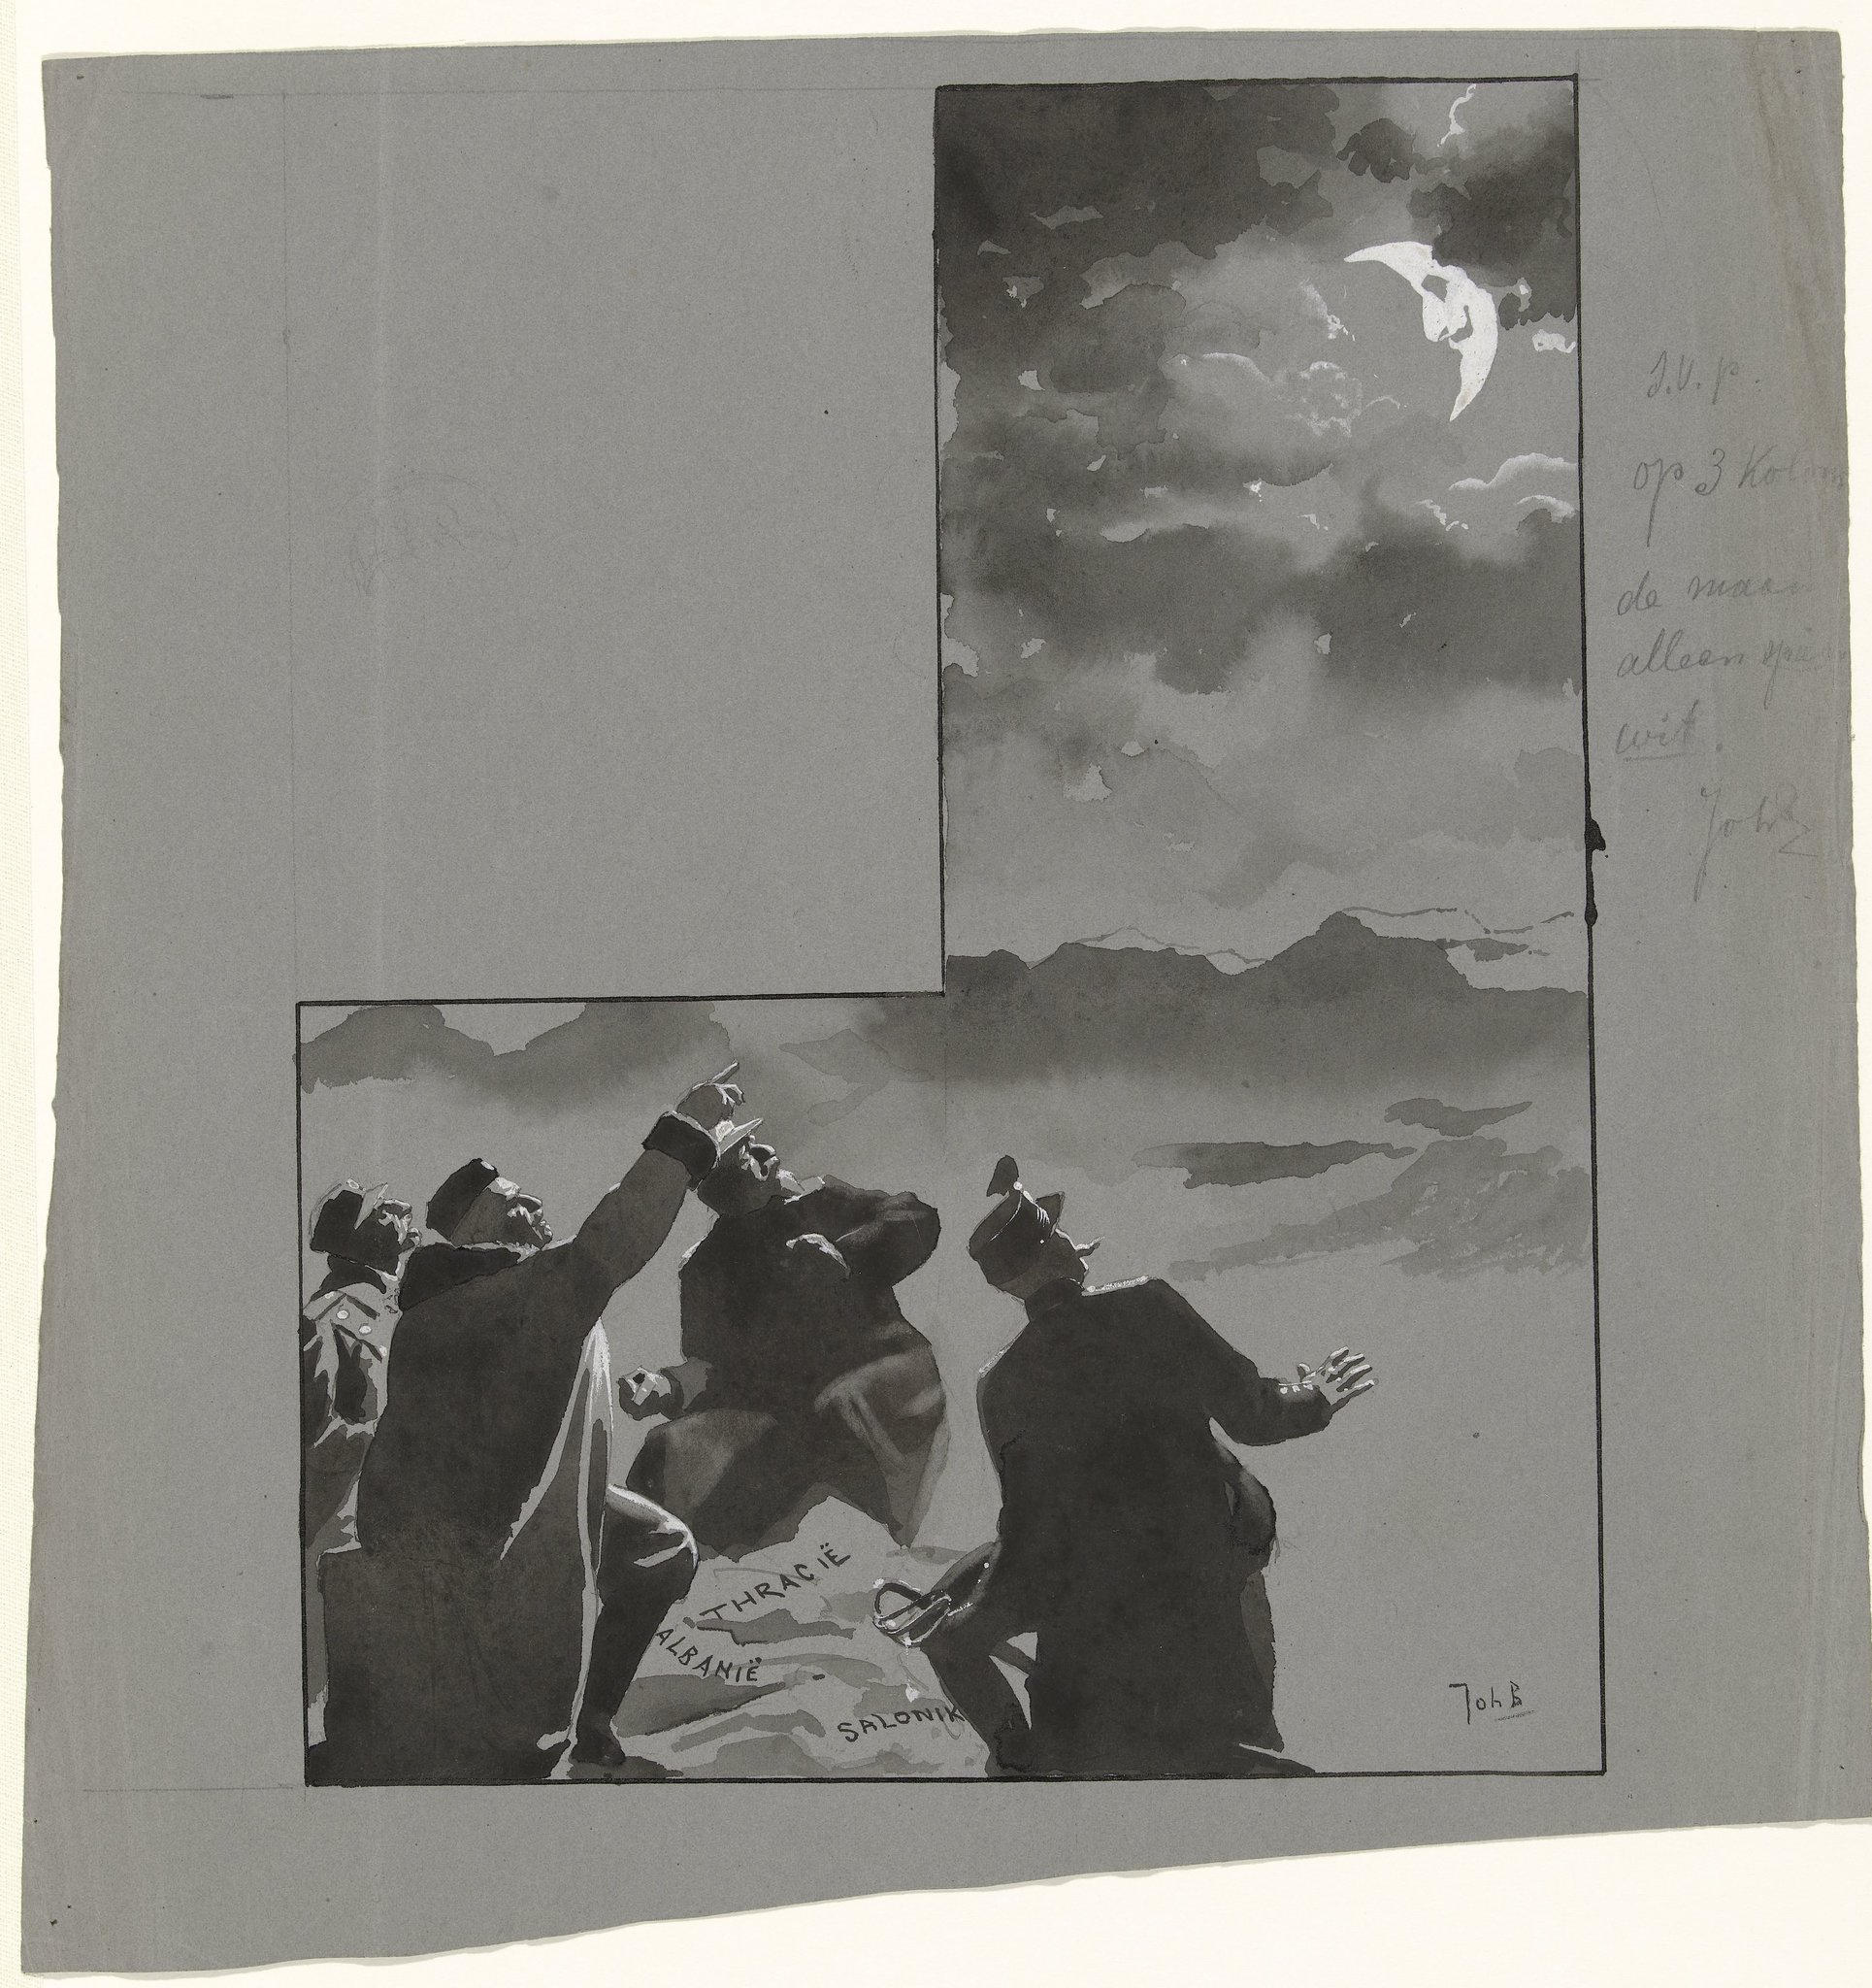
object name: design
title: Ontwerp voor illustratie in De Amsterdammer: De Balkanroovers: De Halve Maan! (2 Februari 1913)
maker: johan braakensiek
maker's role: draughtsman, print maker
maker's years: 1858-1940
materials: paint, paper, pencil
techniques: brush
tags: historical events and situations, political caricatures and satires